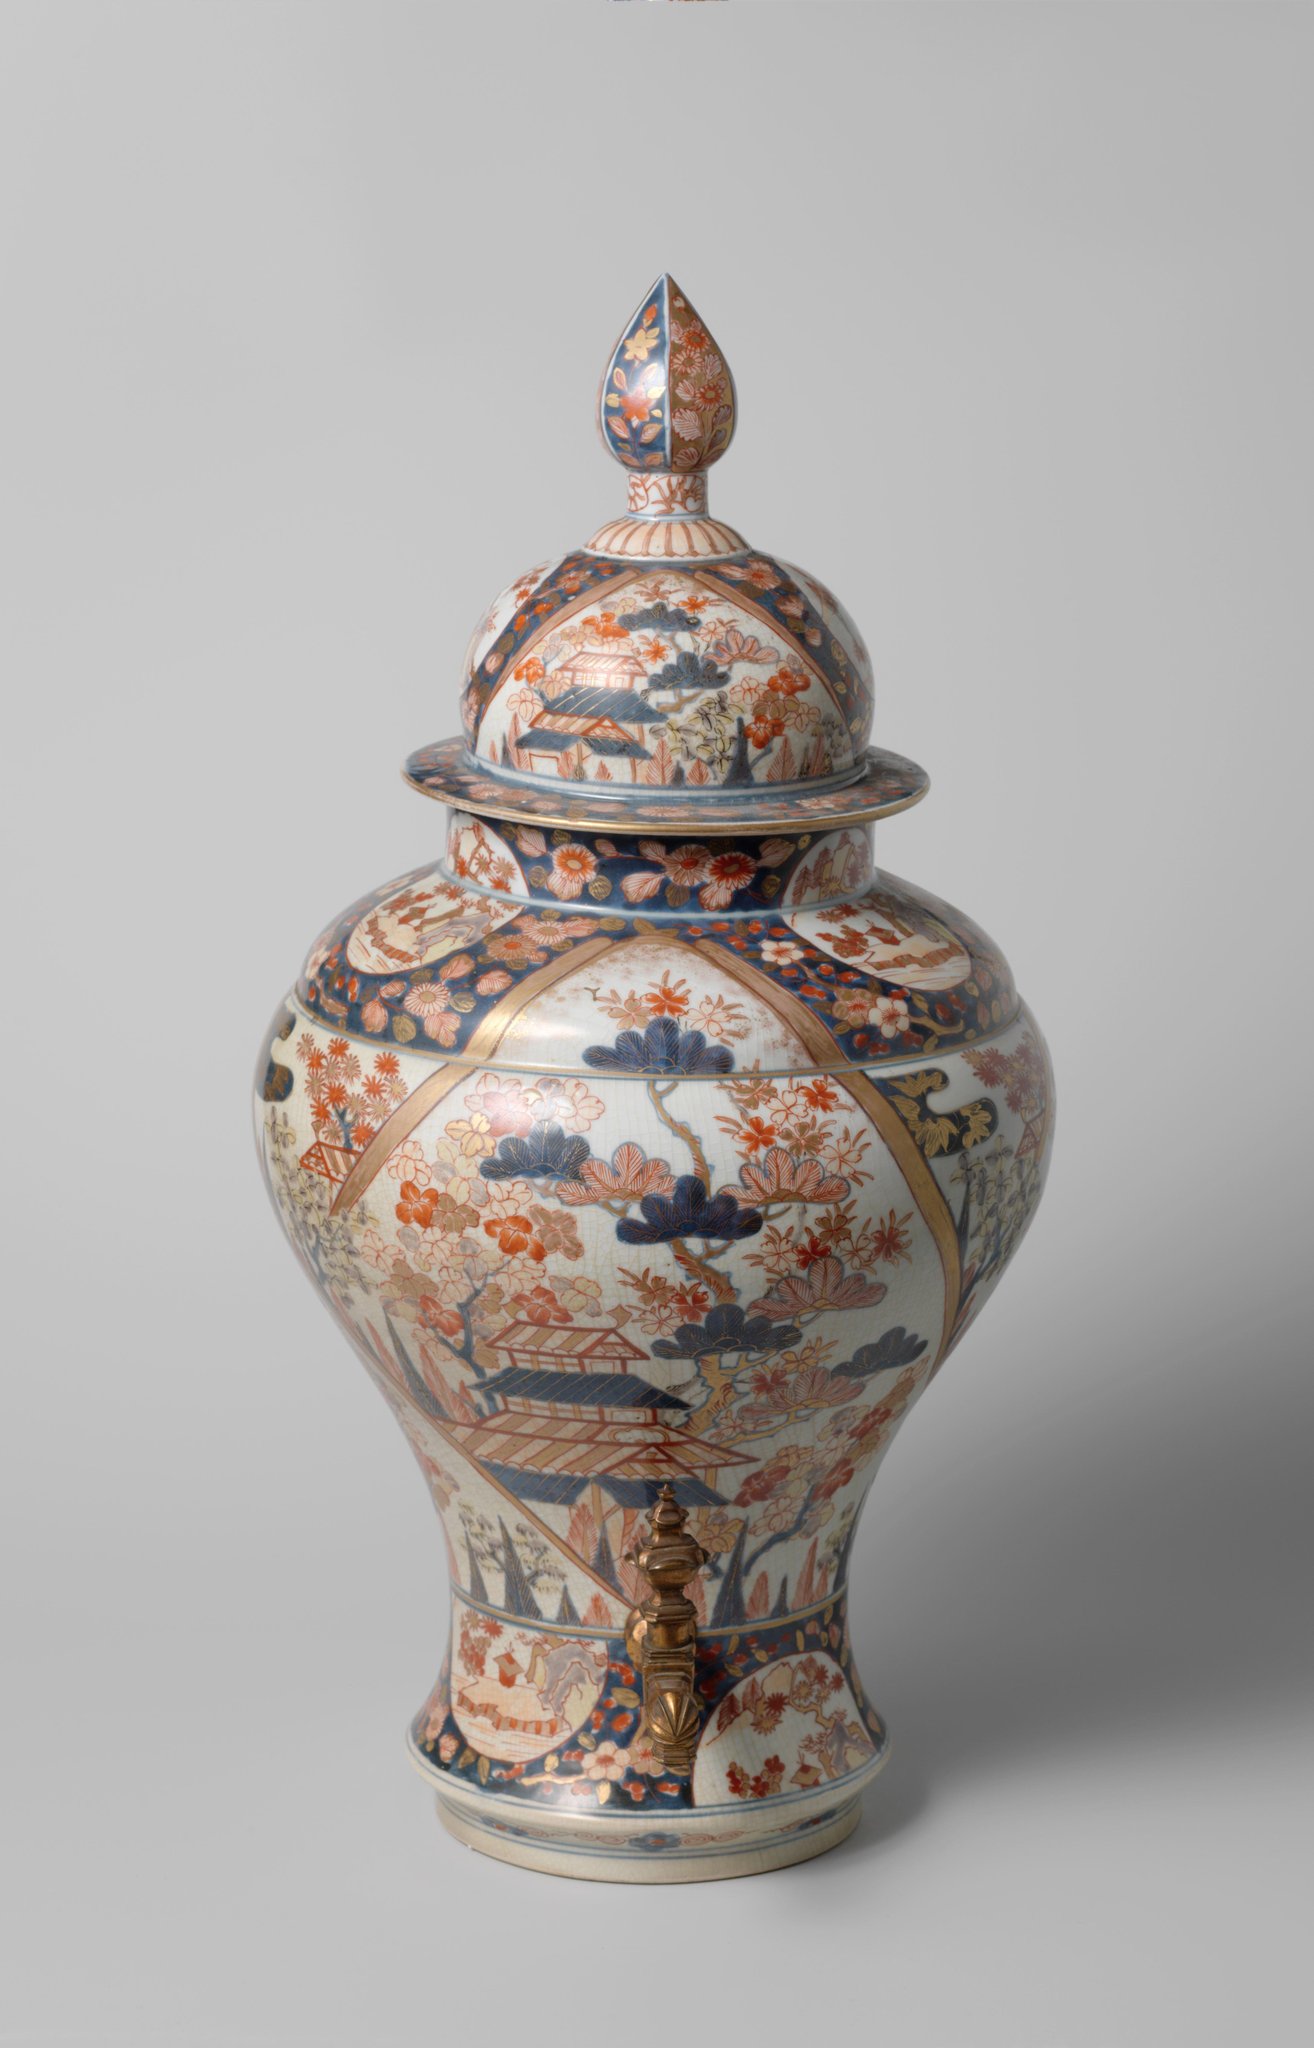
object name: fonteinpot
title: Fountain jar with landscapes and flower sprays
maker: Anonymous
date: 1750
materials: cobalt, glaze, gold, metal, paint, porcelain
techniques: firing, gilding, turning, vitrification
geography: japan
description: Fonteinpot van porselein, beschilderd in onderglazuur blauw en op het glazuur rood en goud. Op de wand drie vakken met een paviljoen bij grote bomen. Rond de voet en op de schouder een band met bloemtakken onderbroken door cartouches met een landschap met een paviljoen, bergen, rotsen en bomen. De deksel met dezelfde decoratie. Onderaan de wand is een kraan aangebracht. Dekselknop is afgebroken geweest; de pot heeft een gecraqueleerd en vergeeld glazuur. Imari.